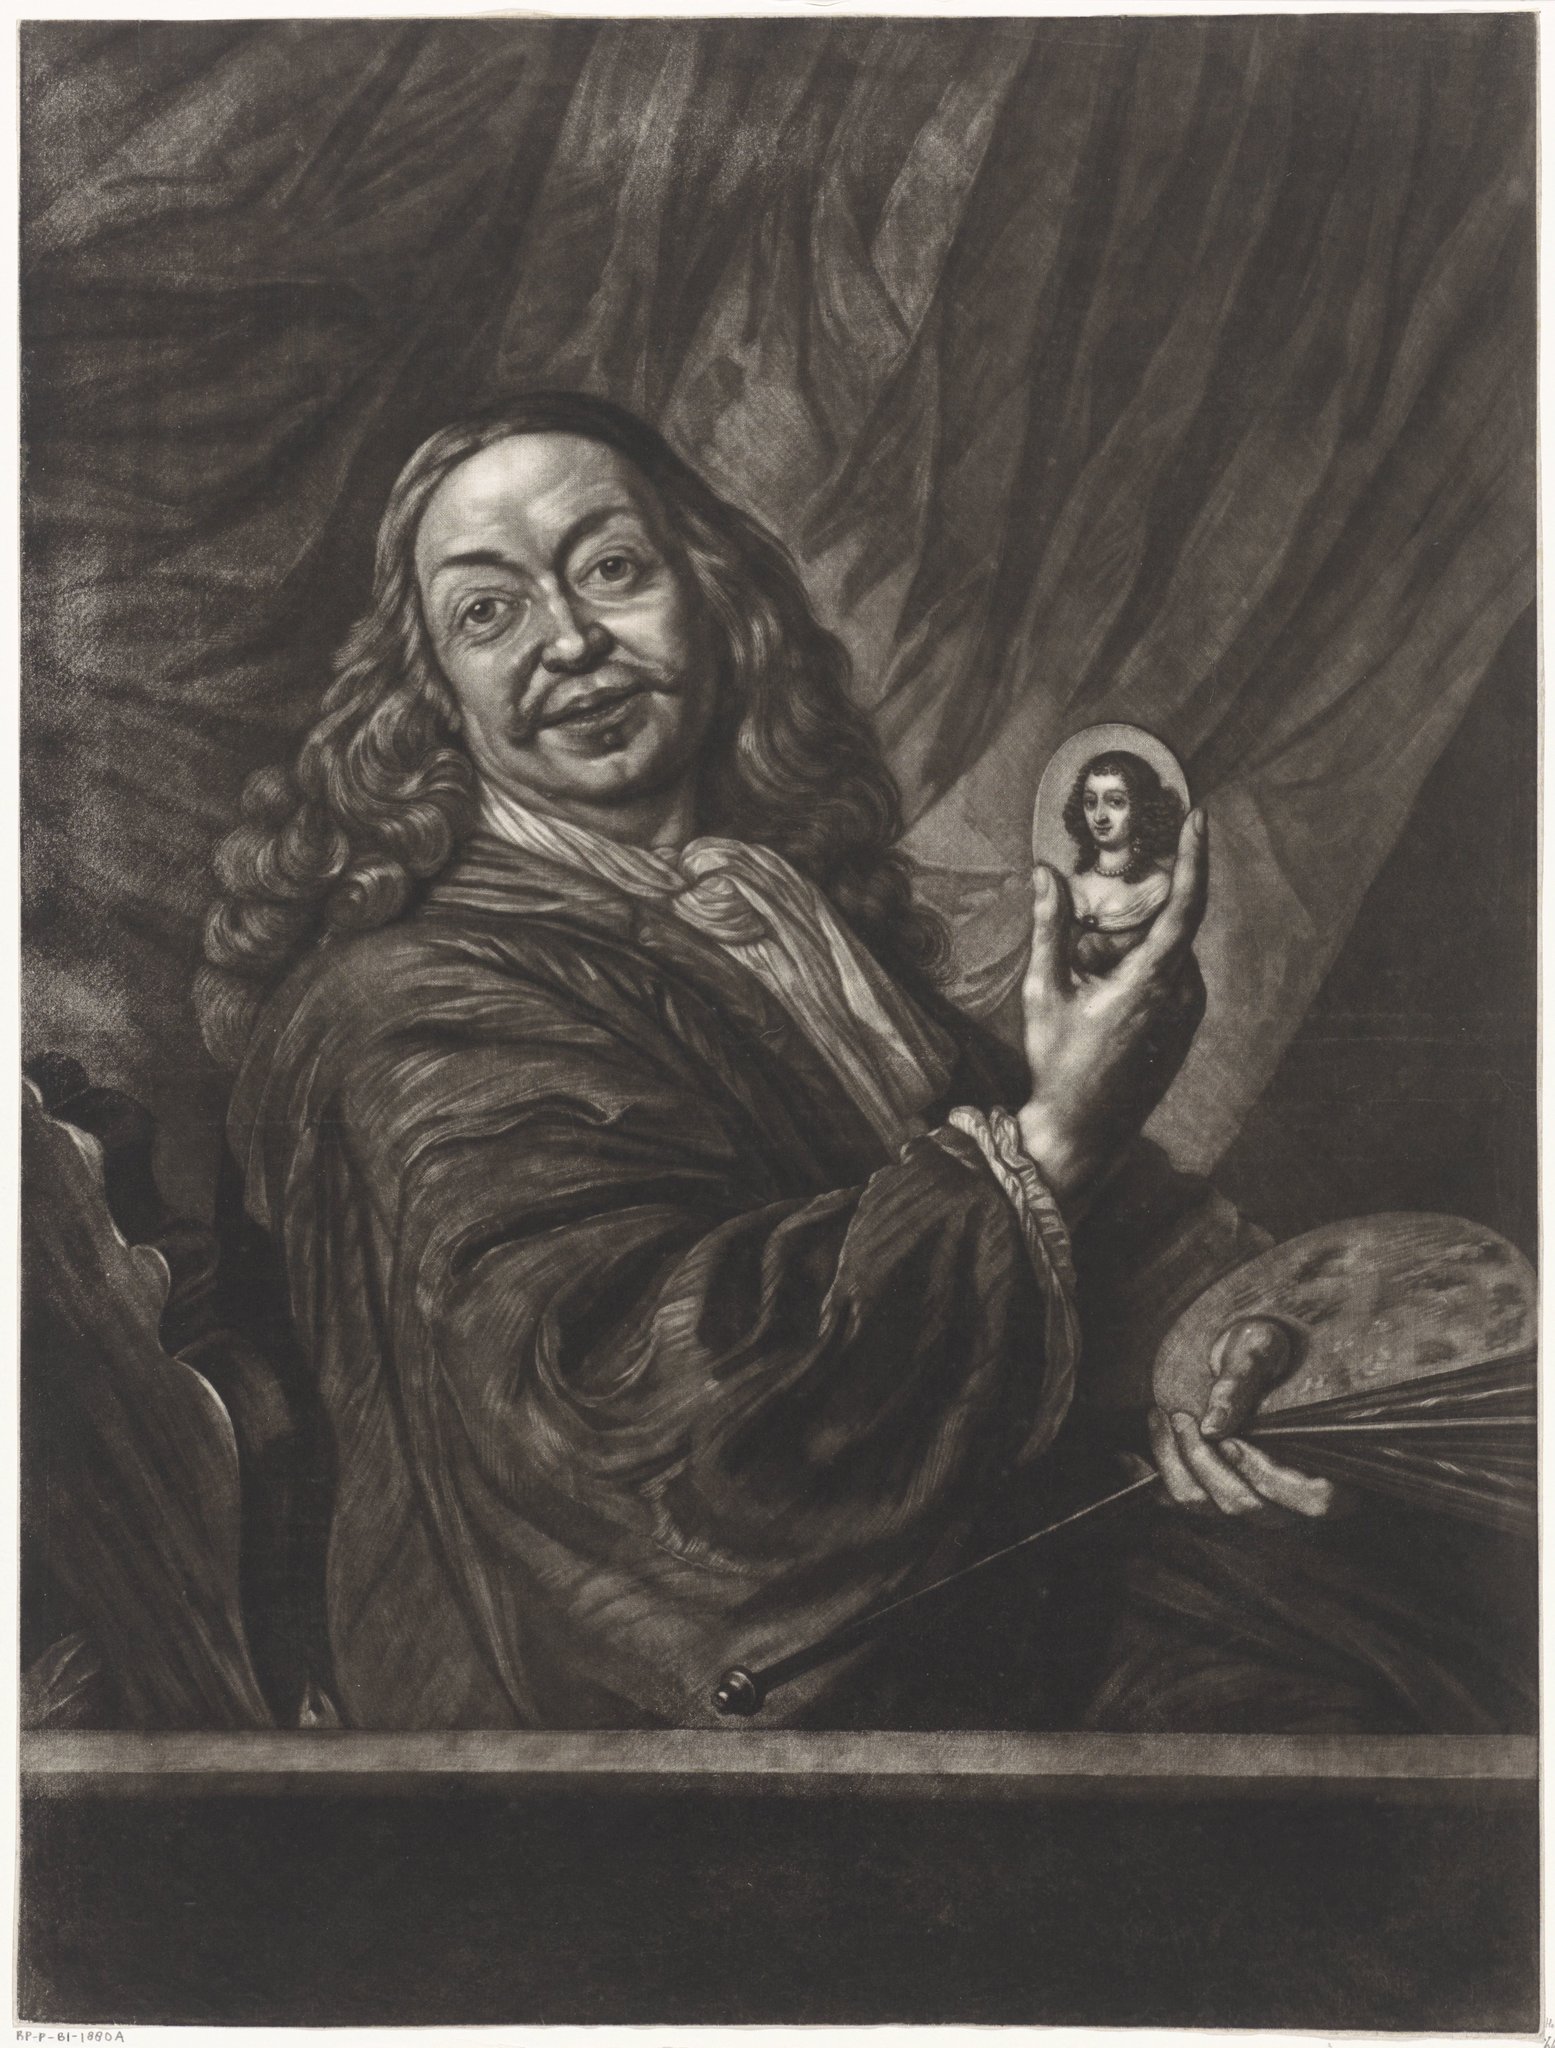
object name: print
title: Portret van Bartholomeus van der Helst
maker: abraham bloteling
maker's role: draughtsman, print maker, publisher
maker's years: 1640-1690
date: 1652-1690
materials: paper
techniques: mezzotint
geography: amsterdam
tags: haarlem, amsterdam, painter, draughtsman, bartholomeus van der helst, portrait, self-portrait of painter, palette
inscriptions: collector's mark: Lugt 240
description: Portret van de schilder Bartholomeus van der Helst, met in zijn rechterhand een miniatuurportret van zijn vrouw Constantia Reynst.